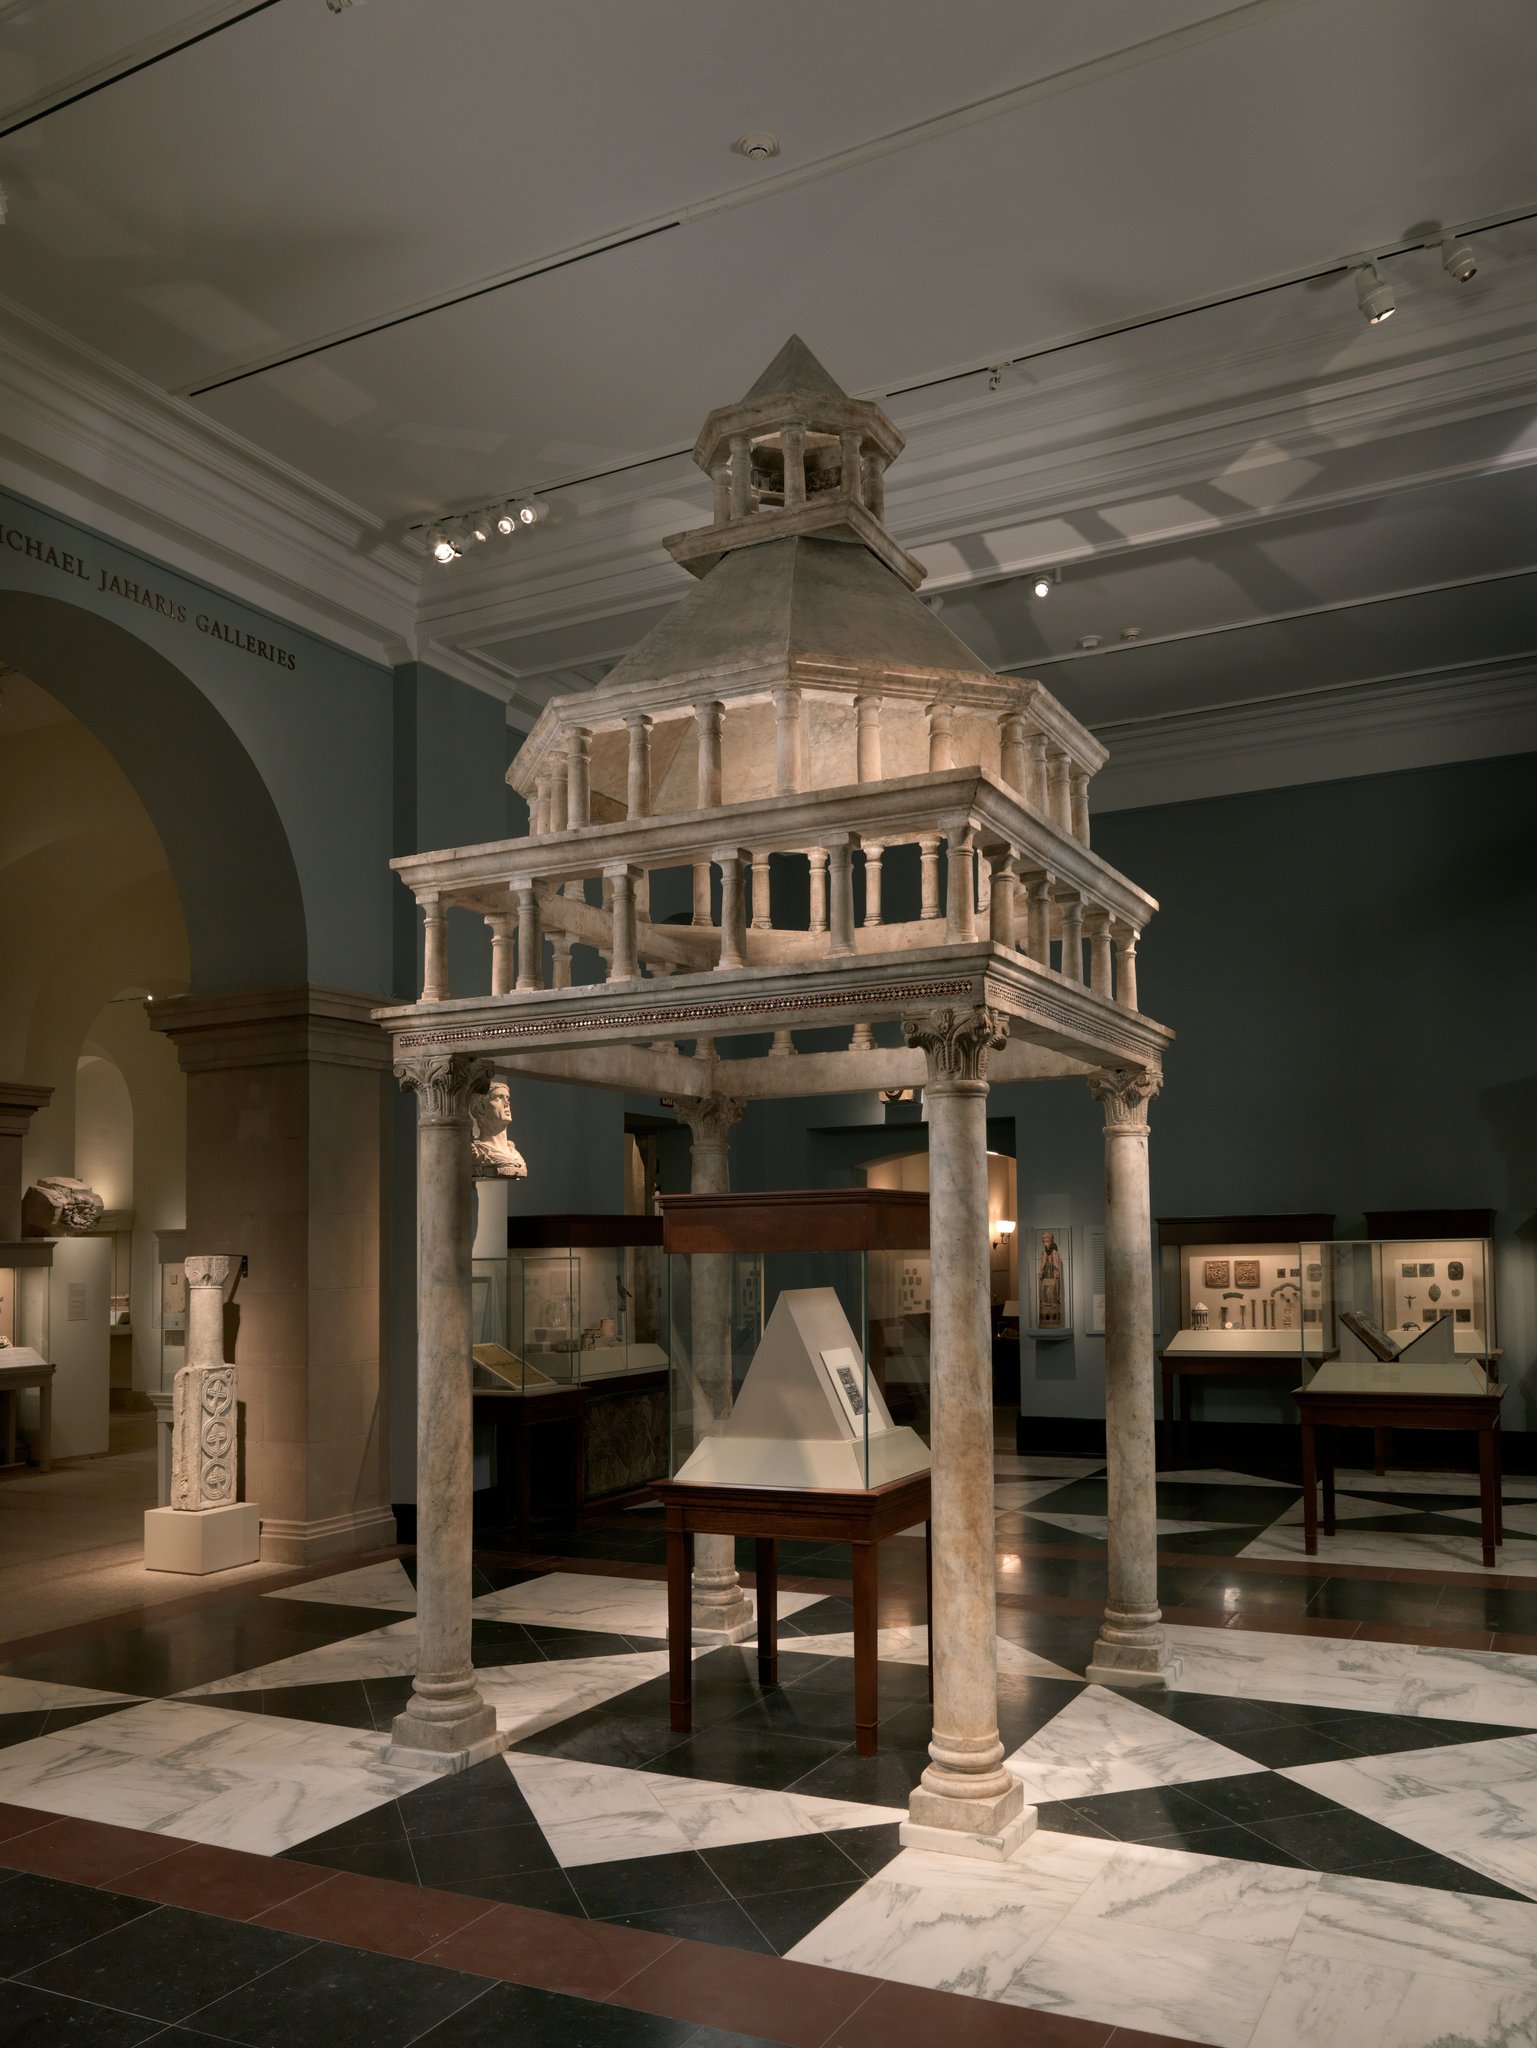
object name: ciborium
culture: italian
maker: nicolaus ranucius (ranierius) and his sons, johannes and guittone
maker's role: artist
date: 1150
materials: glass, gold, marble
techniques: inlay